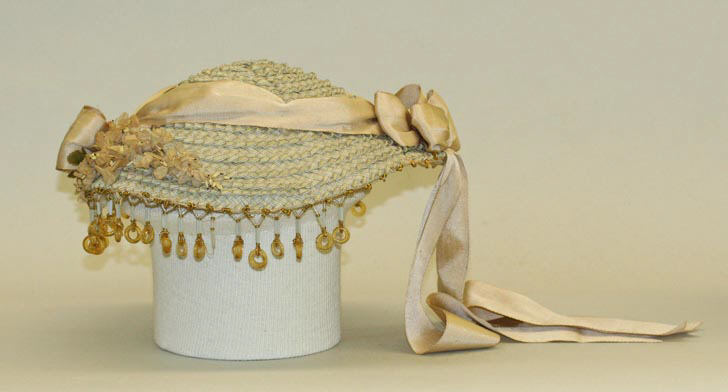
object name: hat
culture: american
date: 1866-1868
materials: silk, fiber